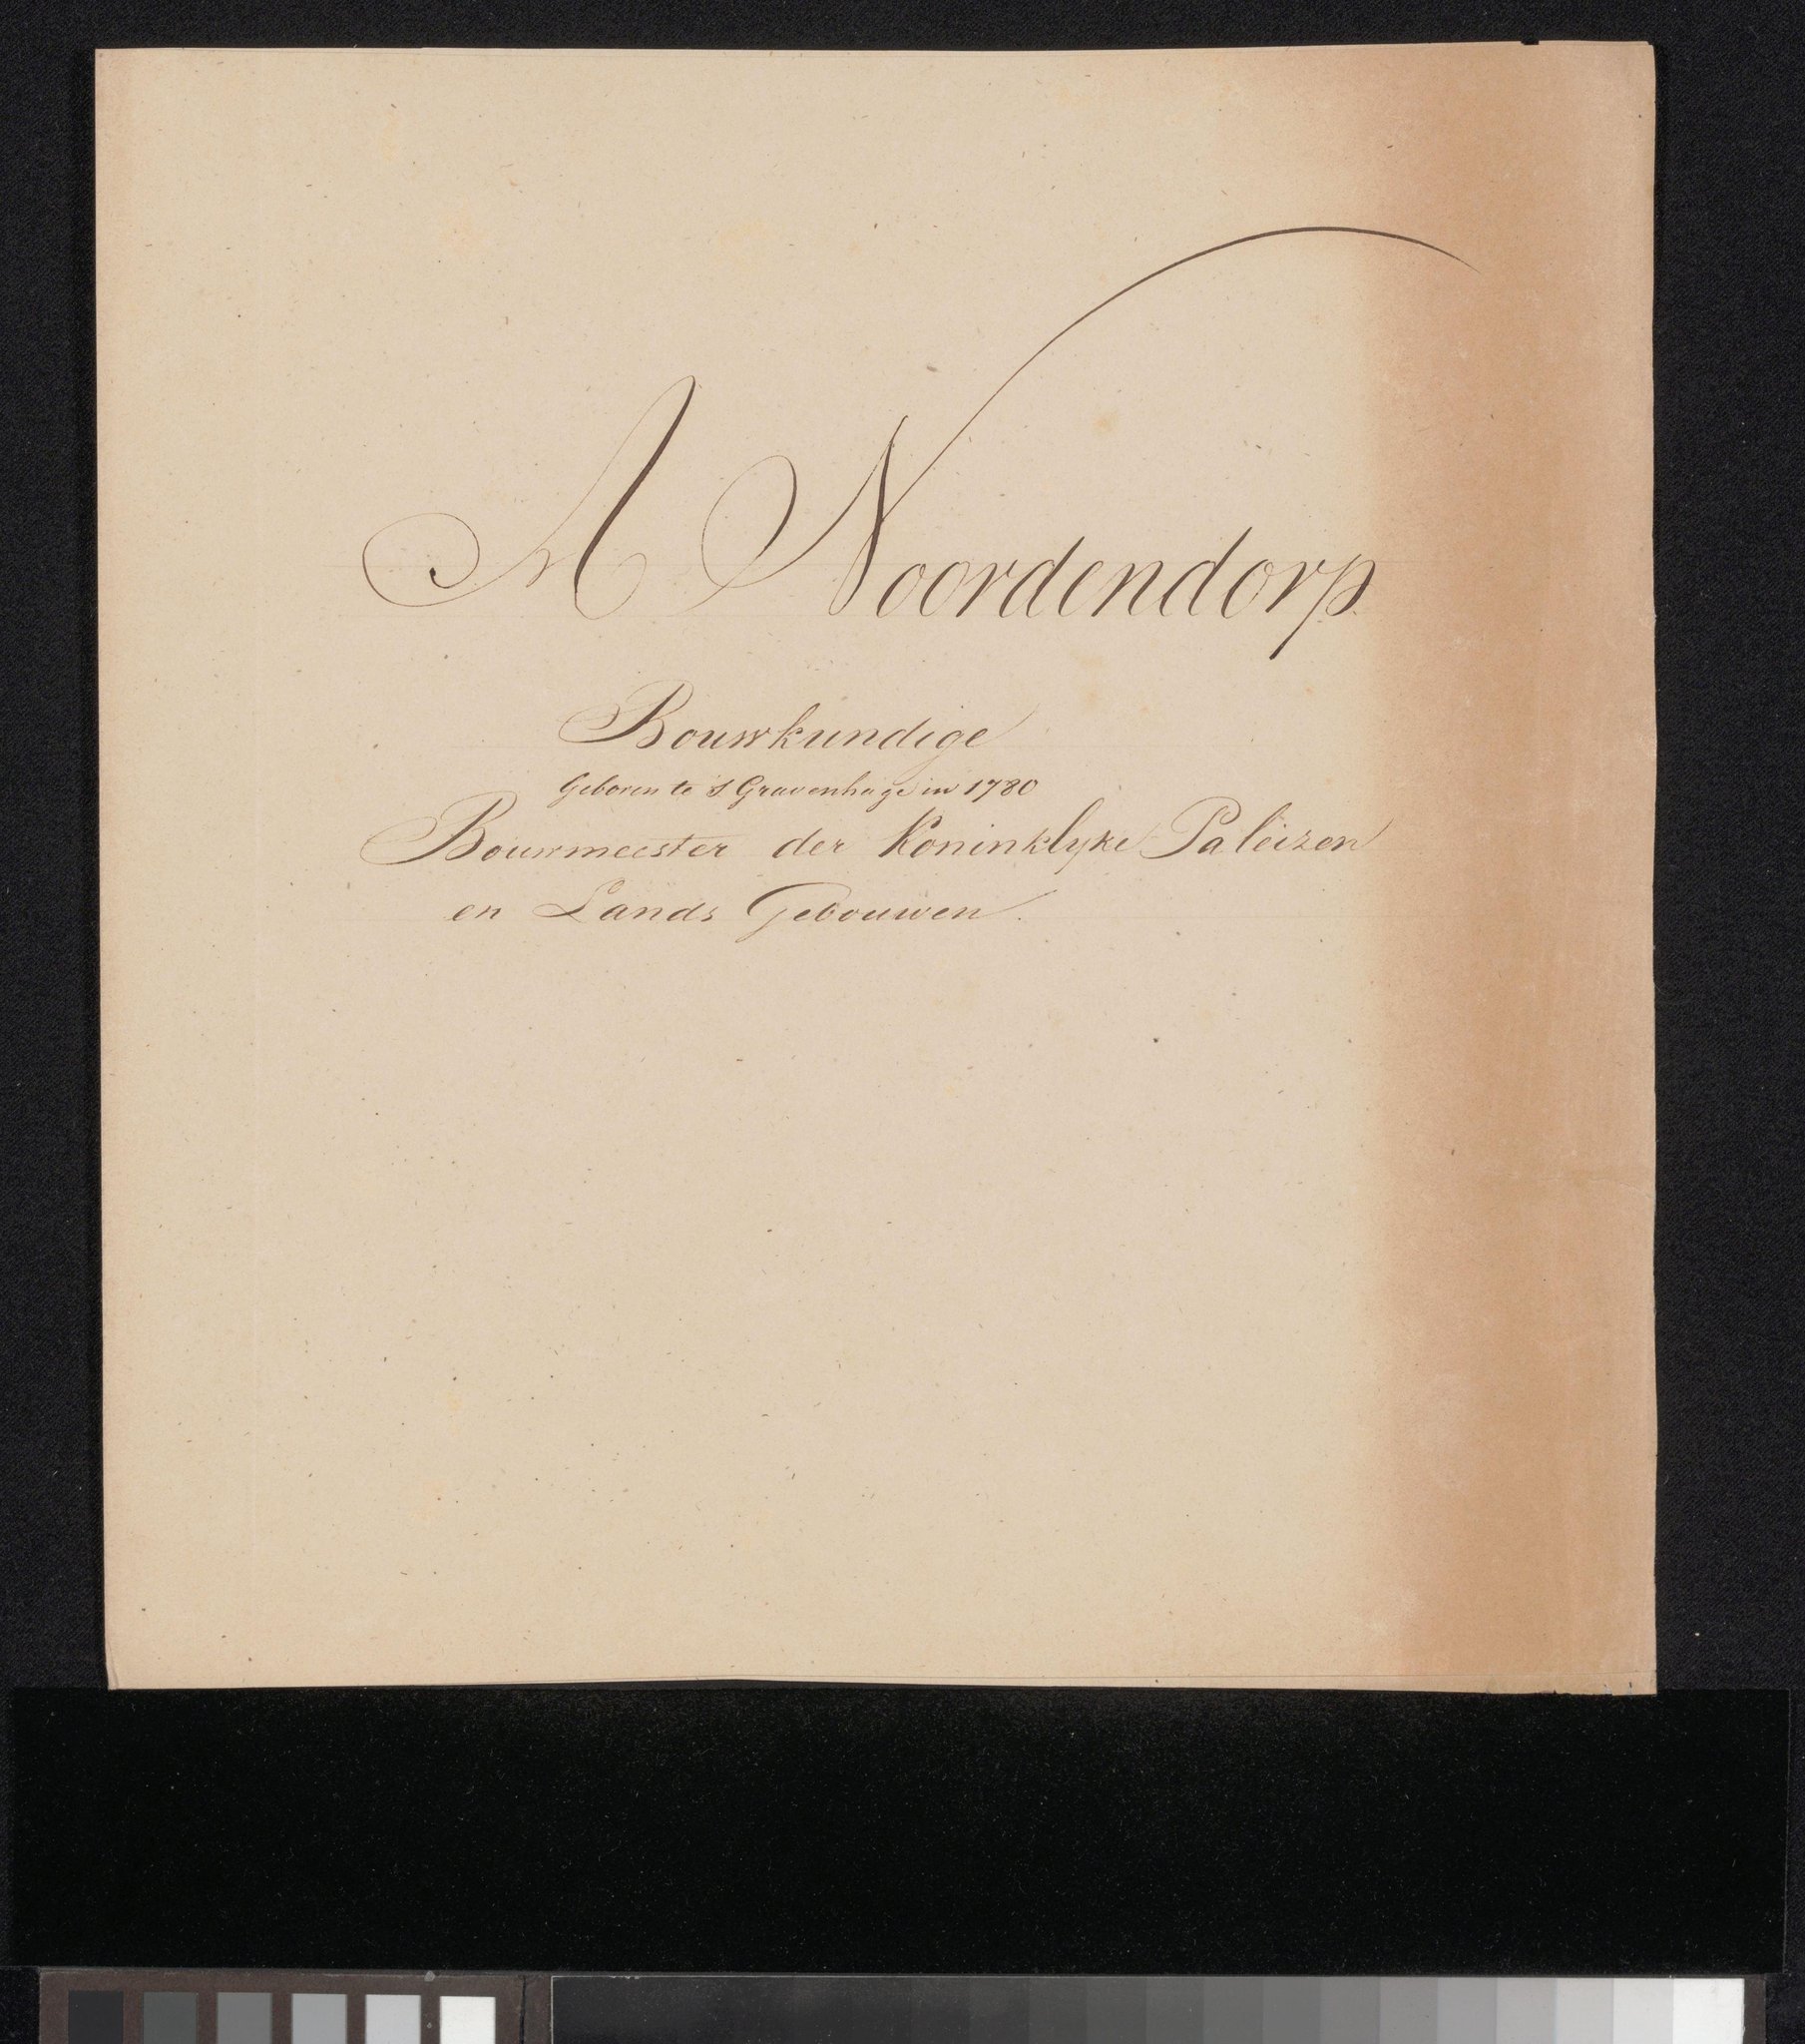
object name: manuscript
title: Handschrift betreffende Adriaan Noordendorp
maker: Anonymous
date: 1790-1833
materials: ink, paper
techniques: pen, writing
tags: the hague, adriaan noordendorp, architecture